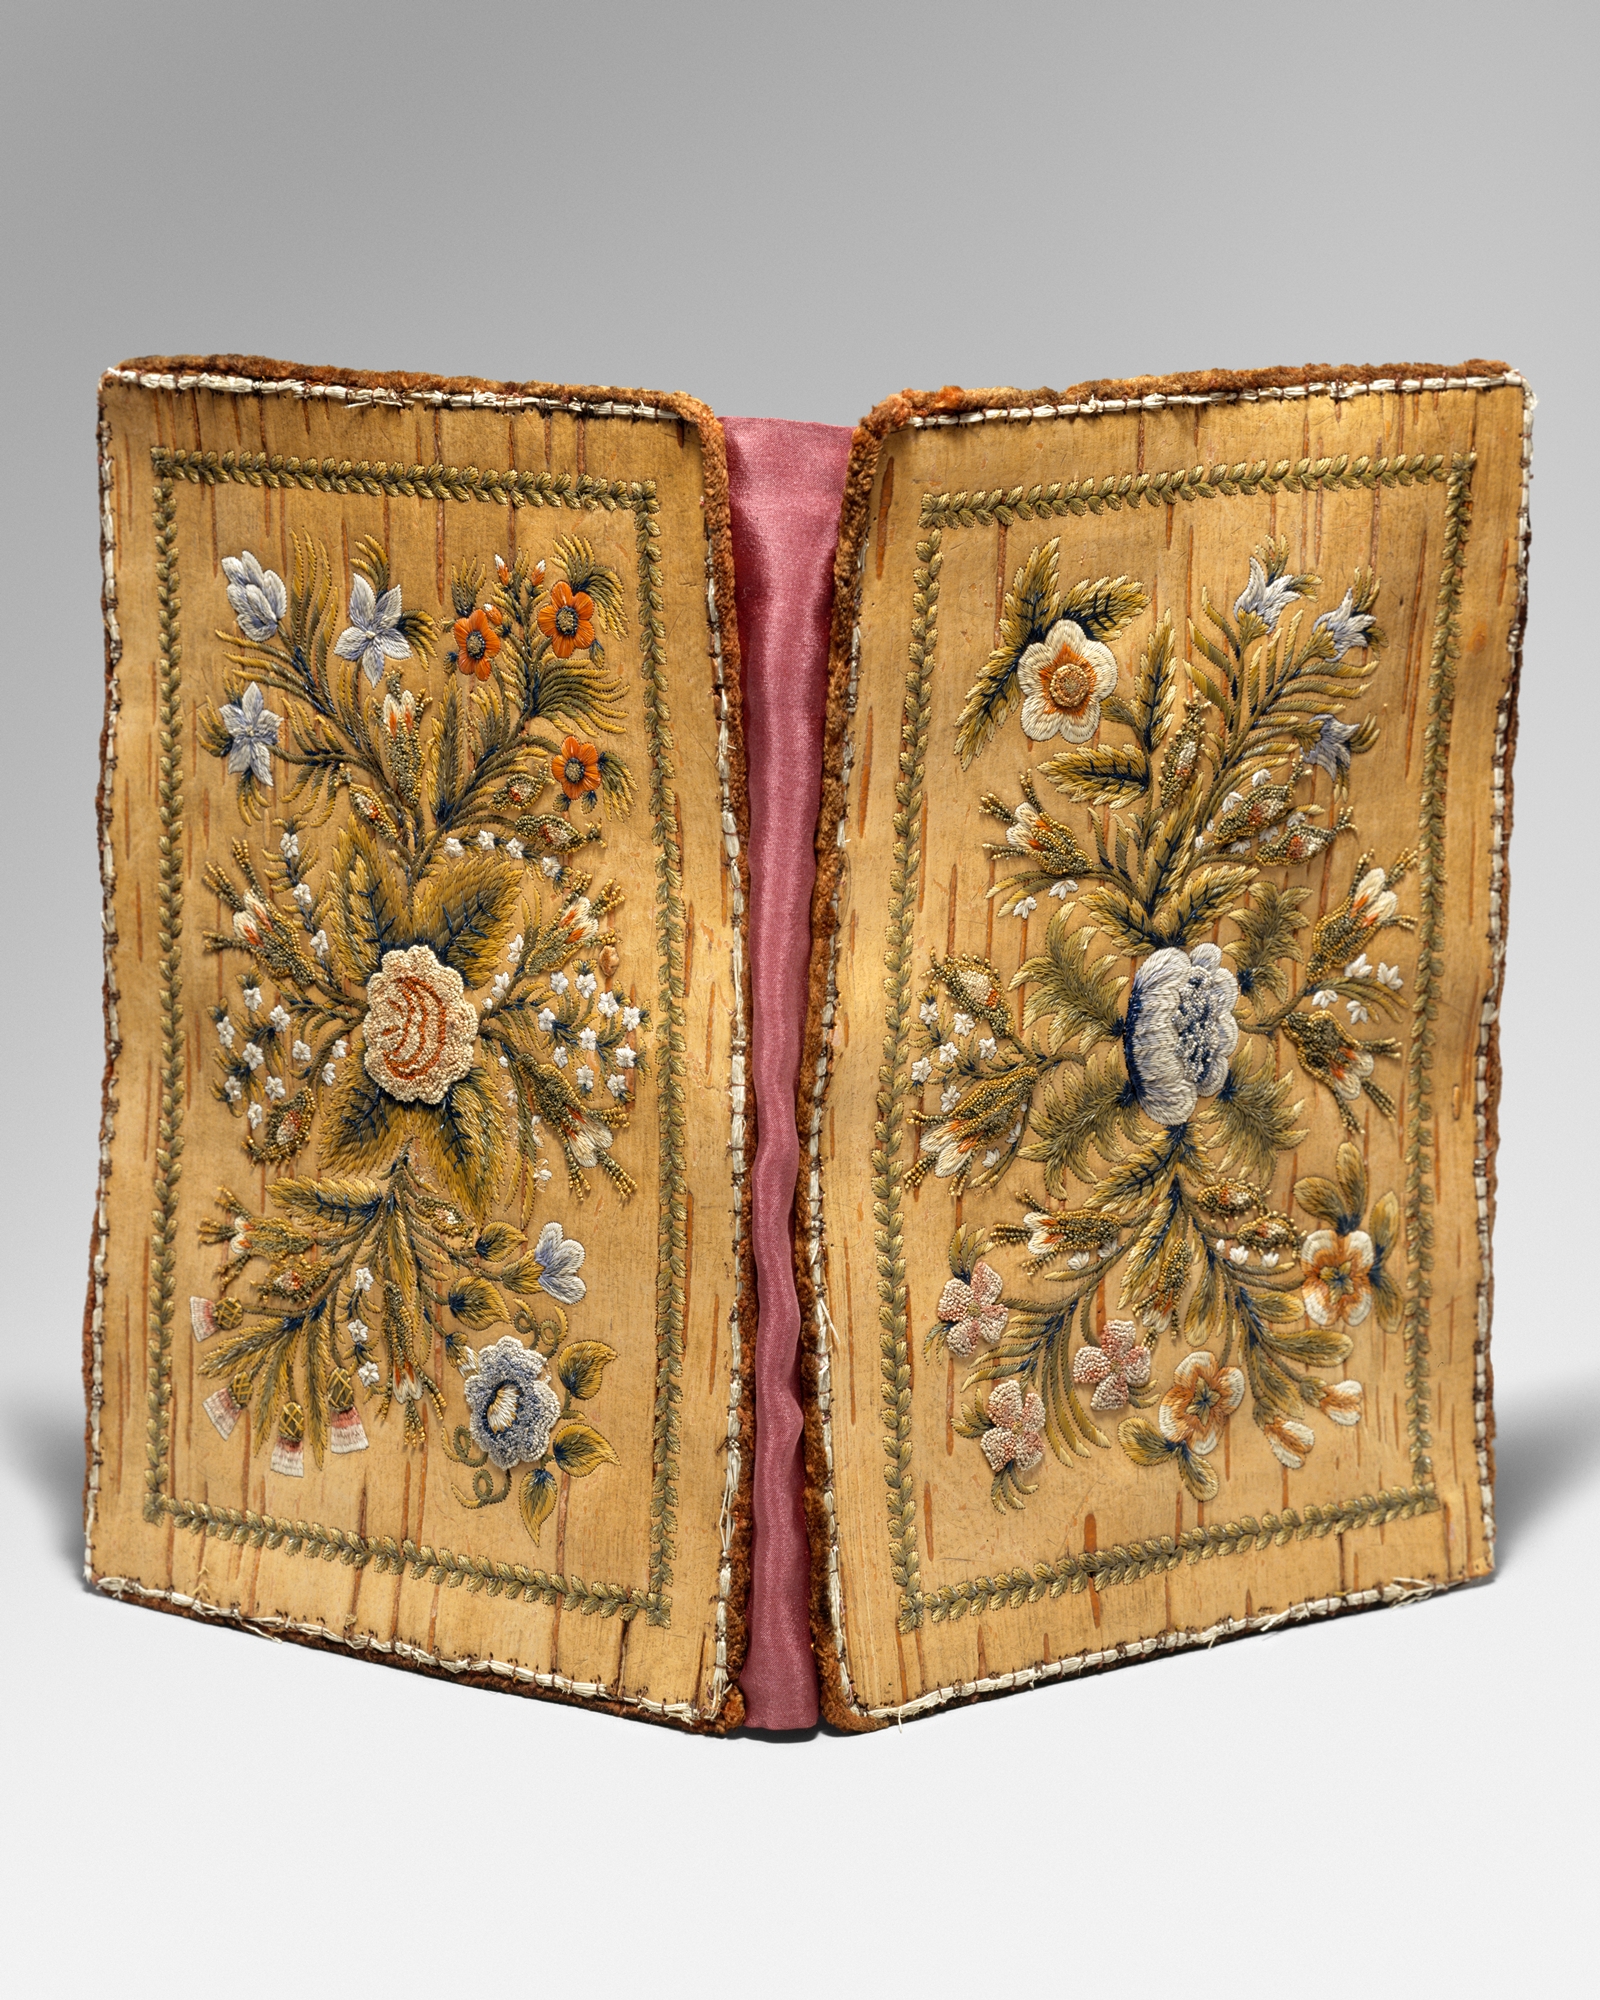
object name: letter case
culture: huron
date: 1835-1840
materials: silk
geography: canada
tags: flowers,leaves